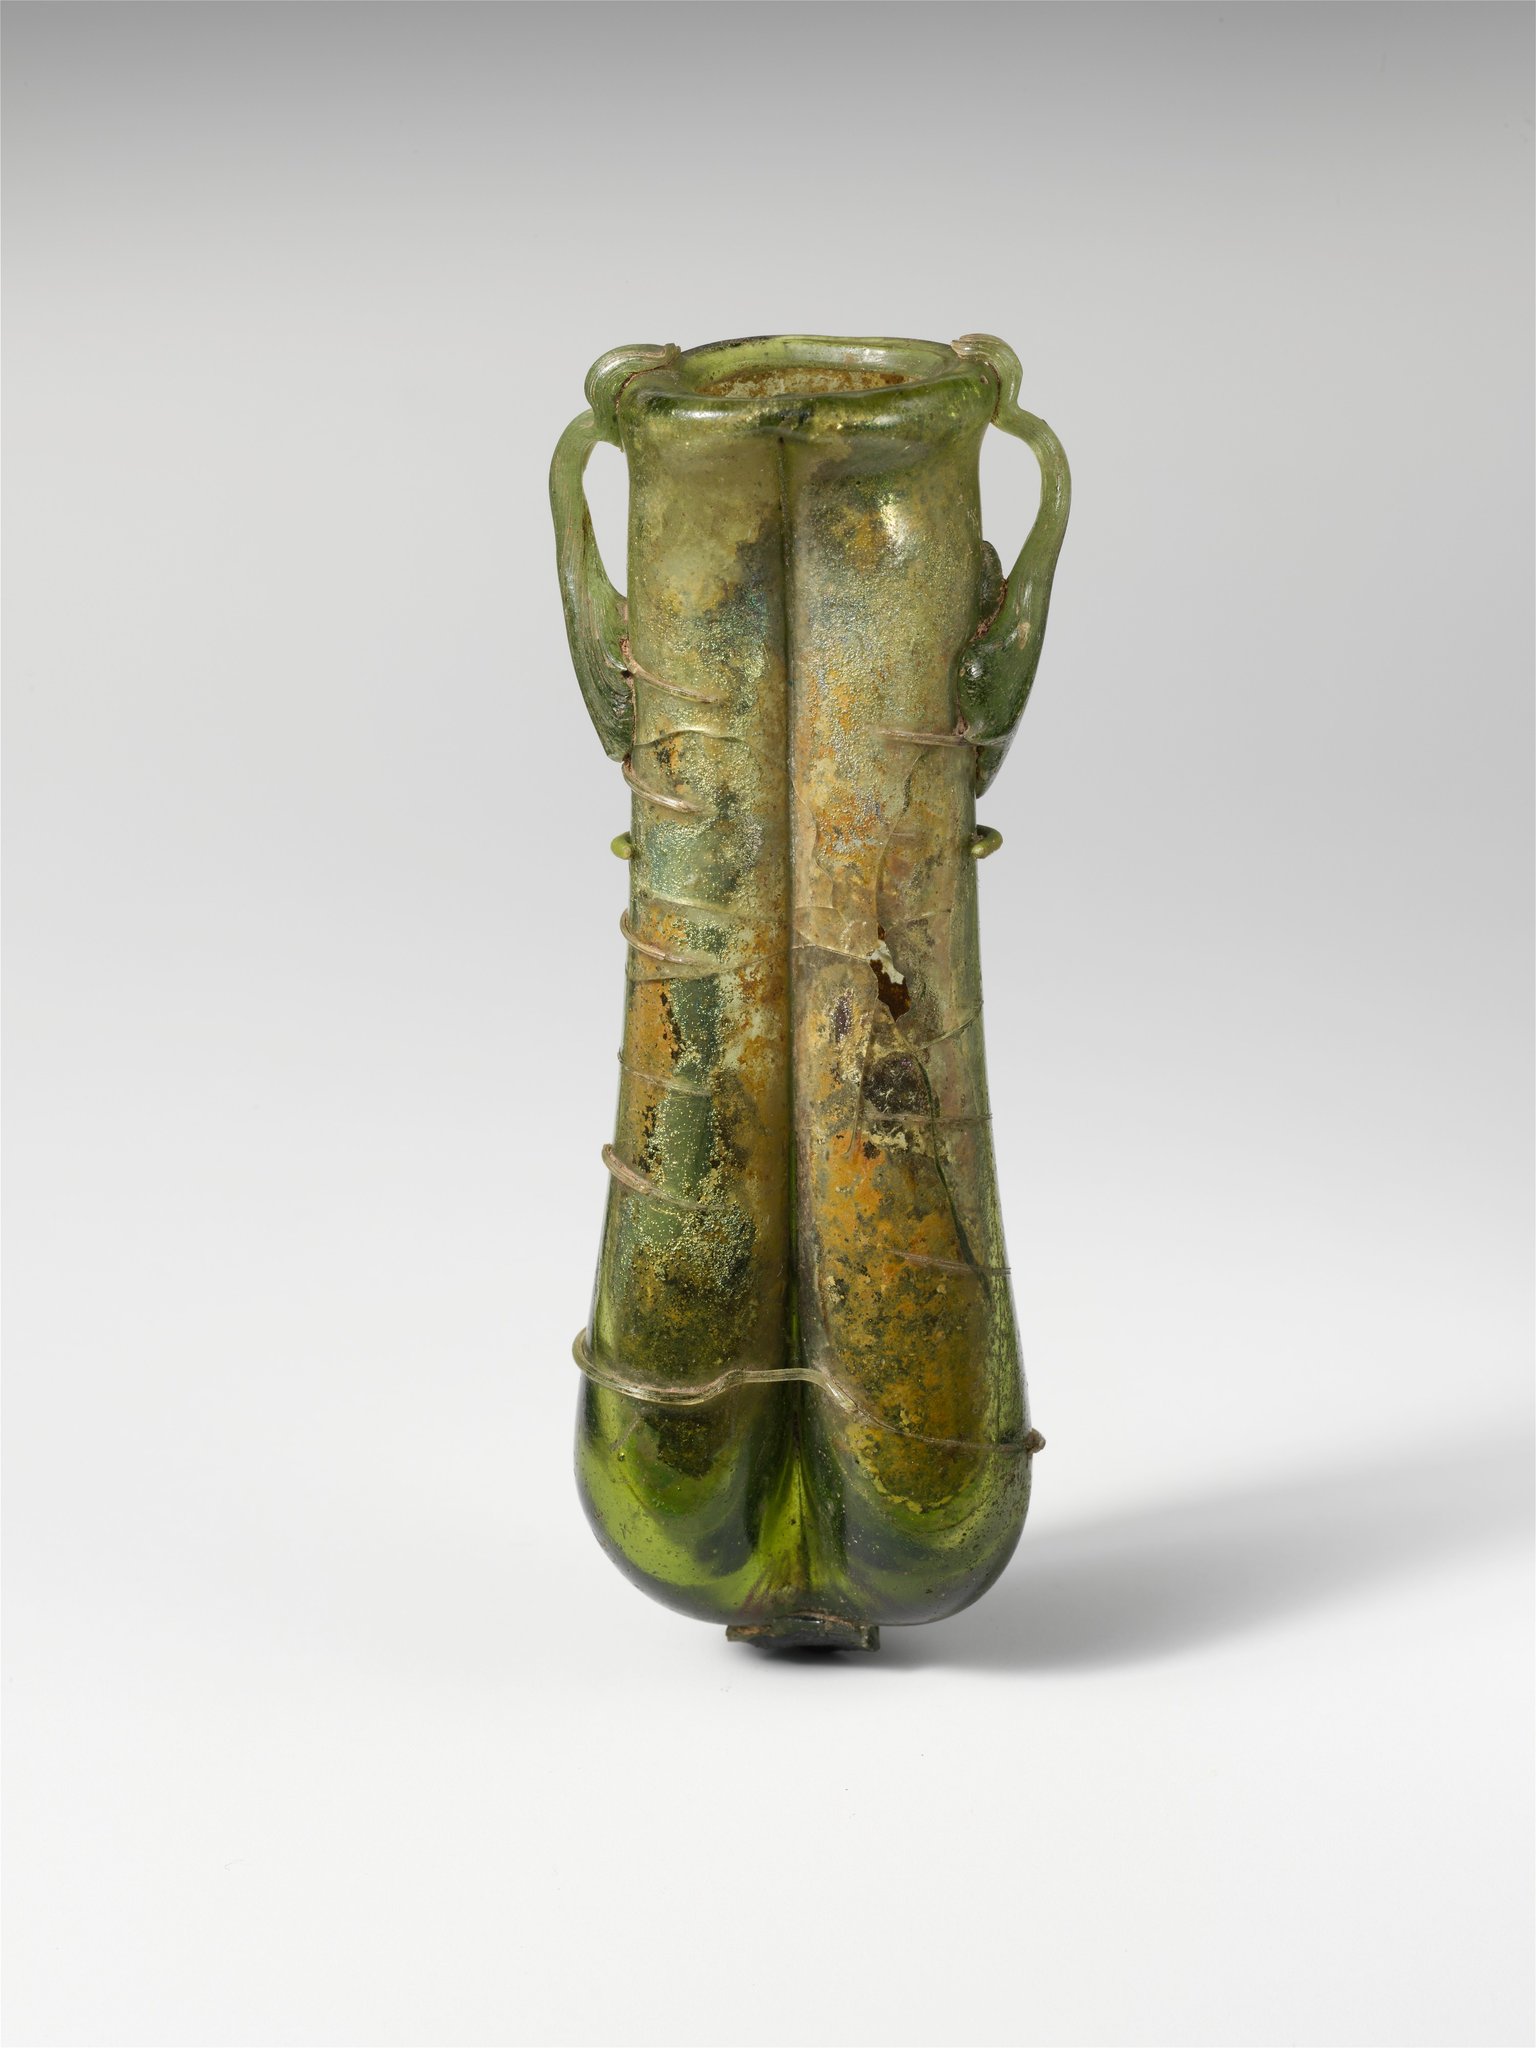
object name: cosmetic flask, double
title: Glass double cosmetic flask (kohl tube)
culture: roman, syrian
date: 301-400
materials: glass